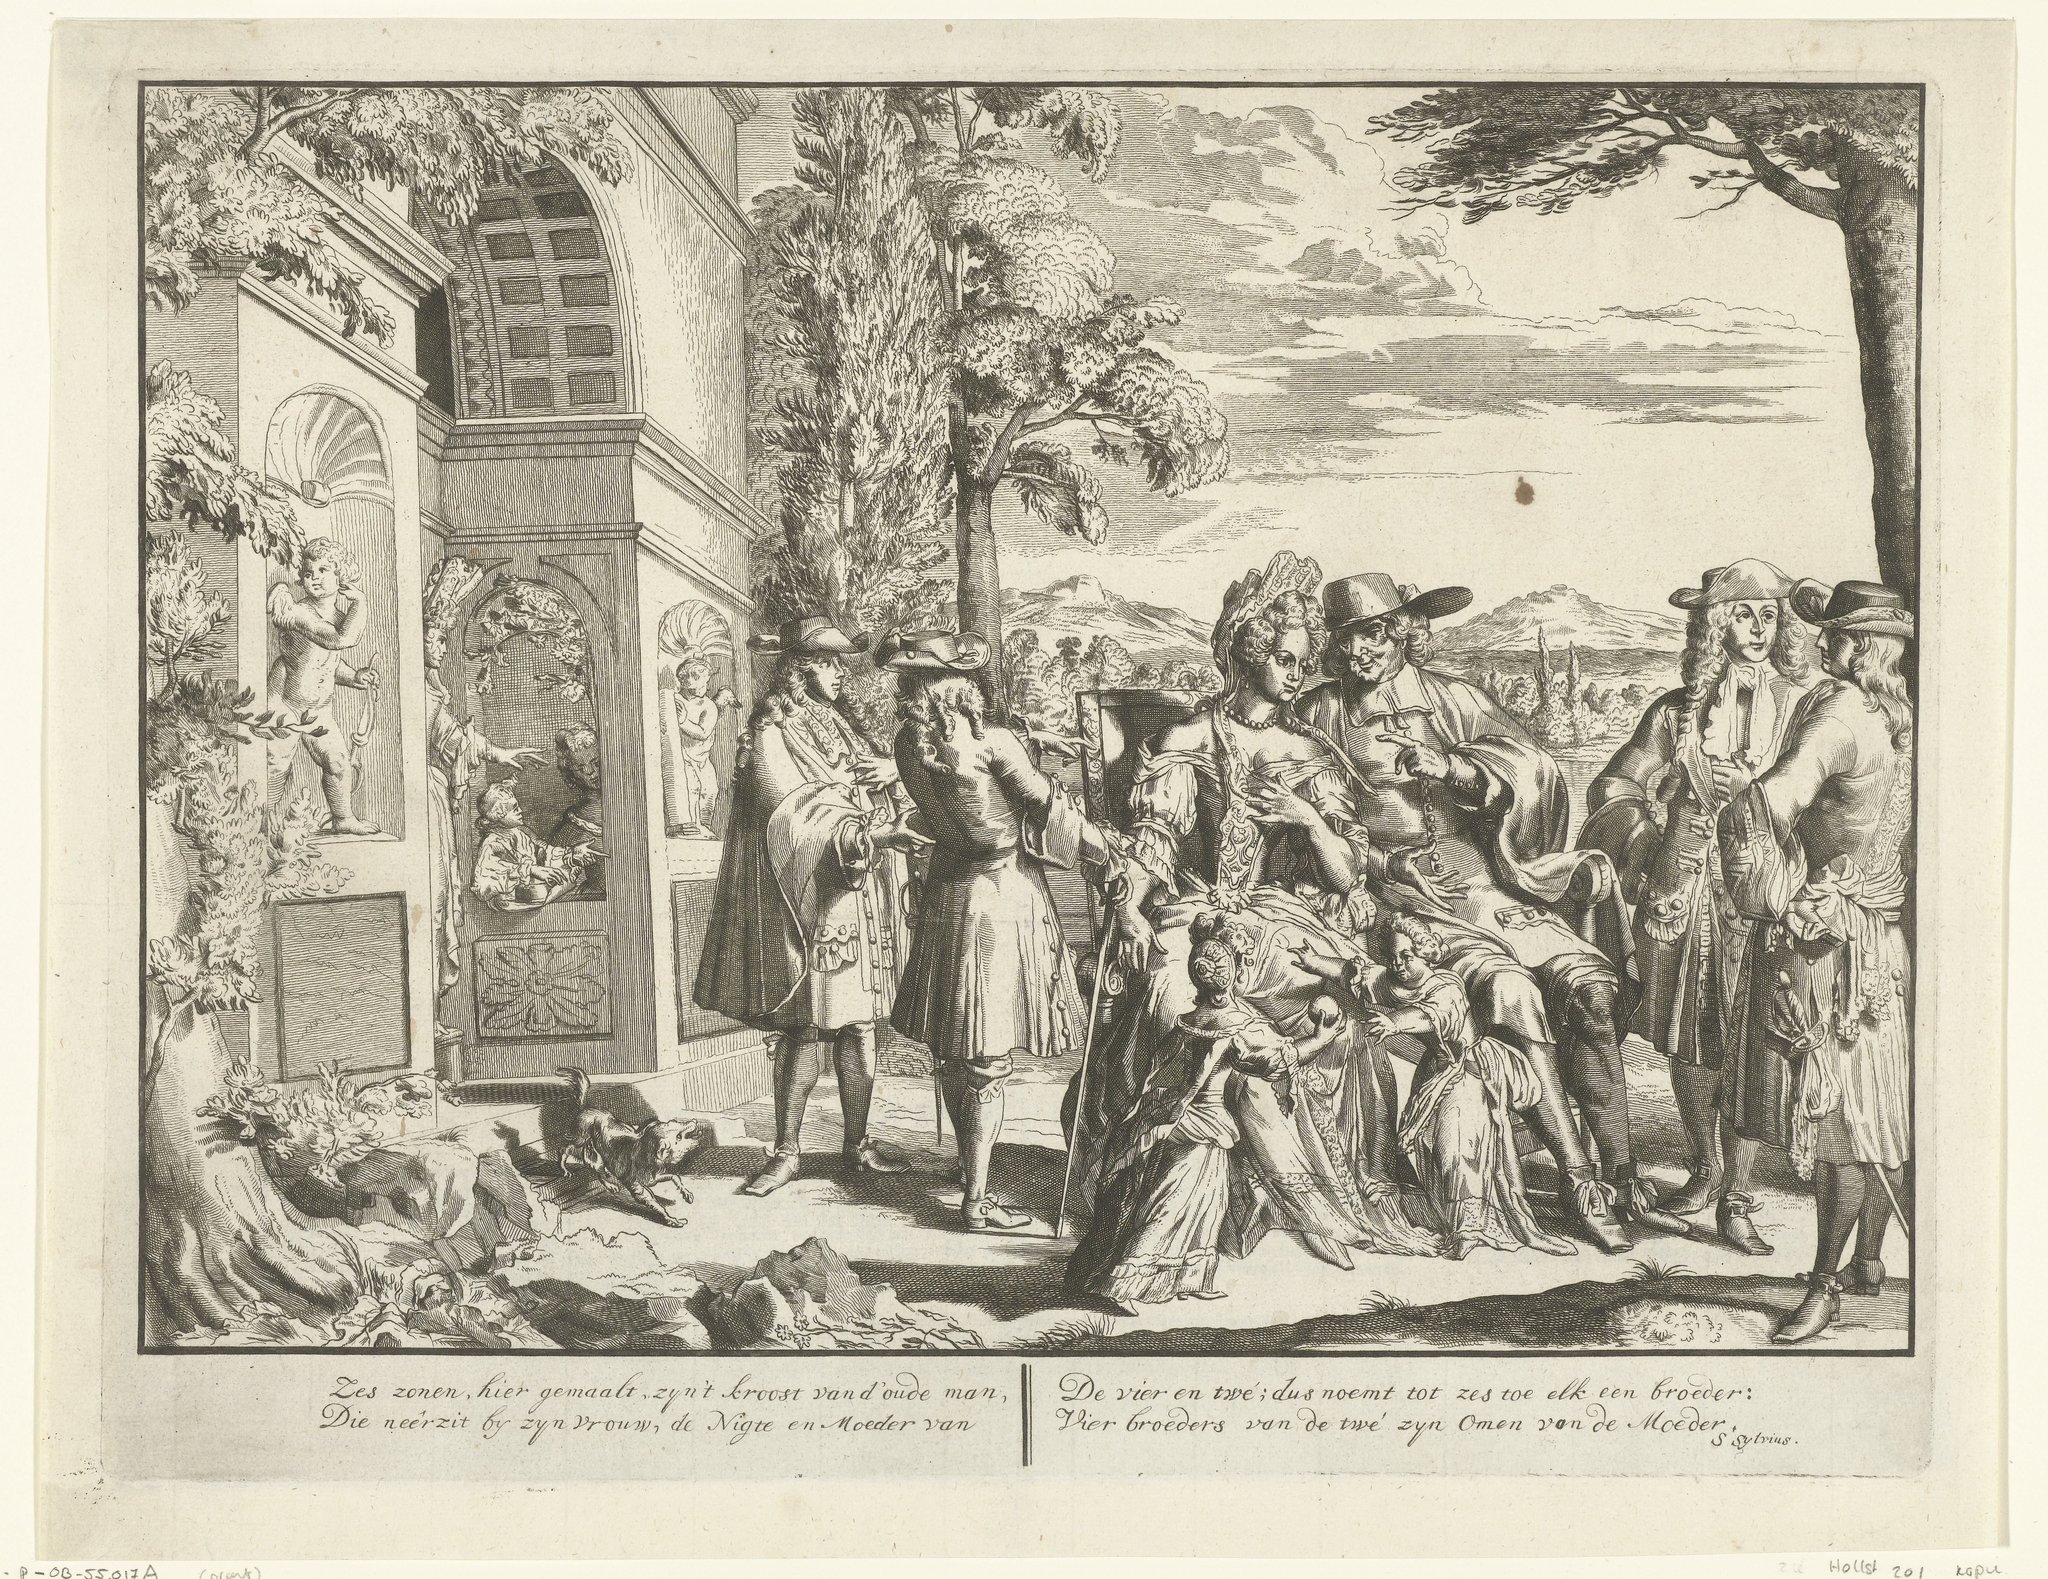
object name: print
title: Het gecompliceerde huwelijk (prent)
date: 1698-1750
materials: paper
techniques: etching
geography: haarlem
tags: parents with their children, family group, especially parents with their child(ren), garden, historical persons, parents (first degree family relationships), nijmegen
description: In een tuin voor een klassiek portaal zit een man naast zijn jonge vrouw temidden van hun zes zonen. Onder de voorstelling vier regels Nederlandse tekst die de relatie tussen de vrouw en de jongens/heren in de voorstelling in de vorm van een raadsel benoemt. Uit de bijbehorende, op een apart blad gedrukte tekst wordt duidelijk hoe de verhoudingen in deze Nijmeegse familie Brakel precies liggen.